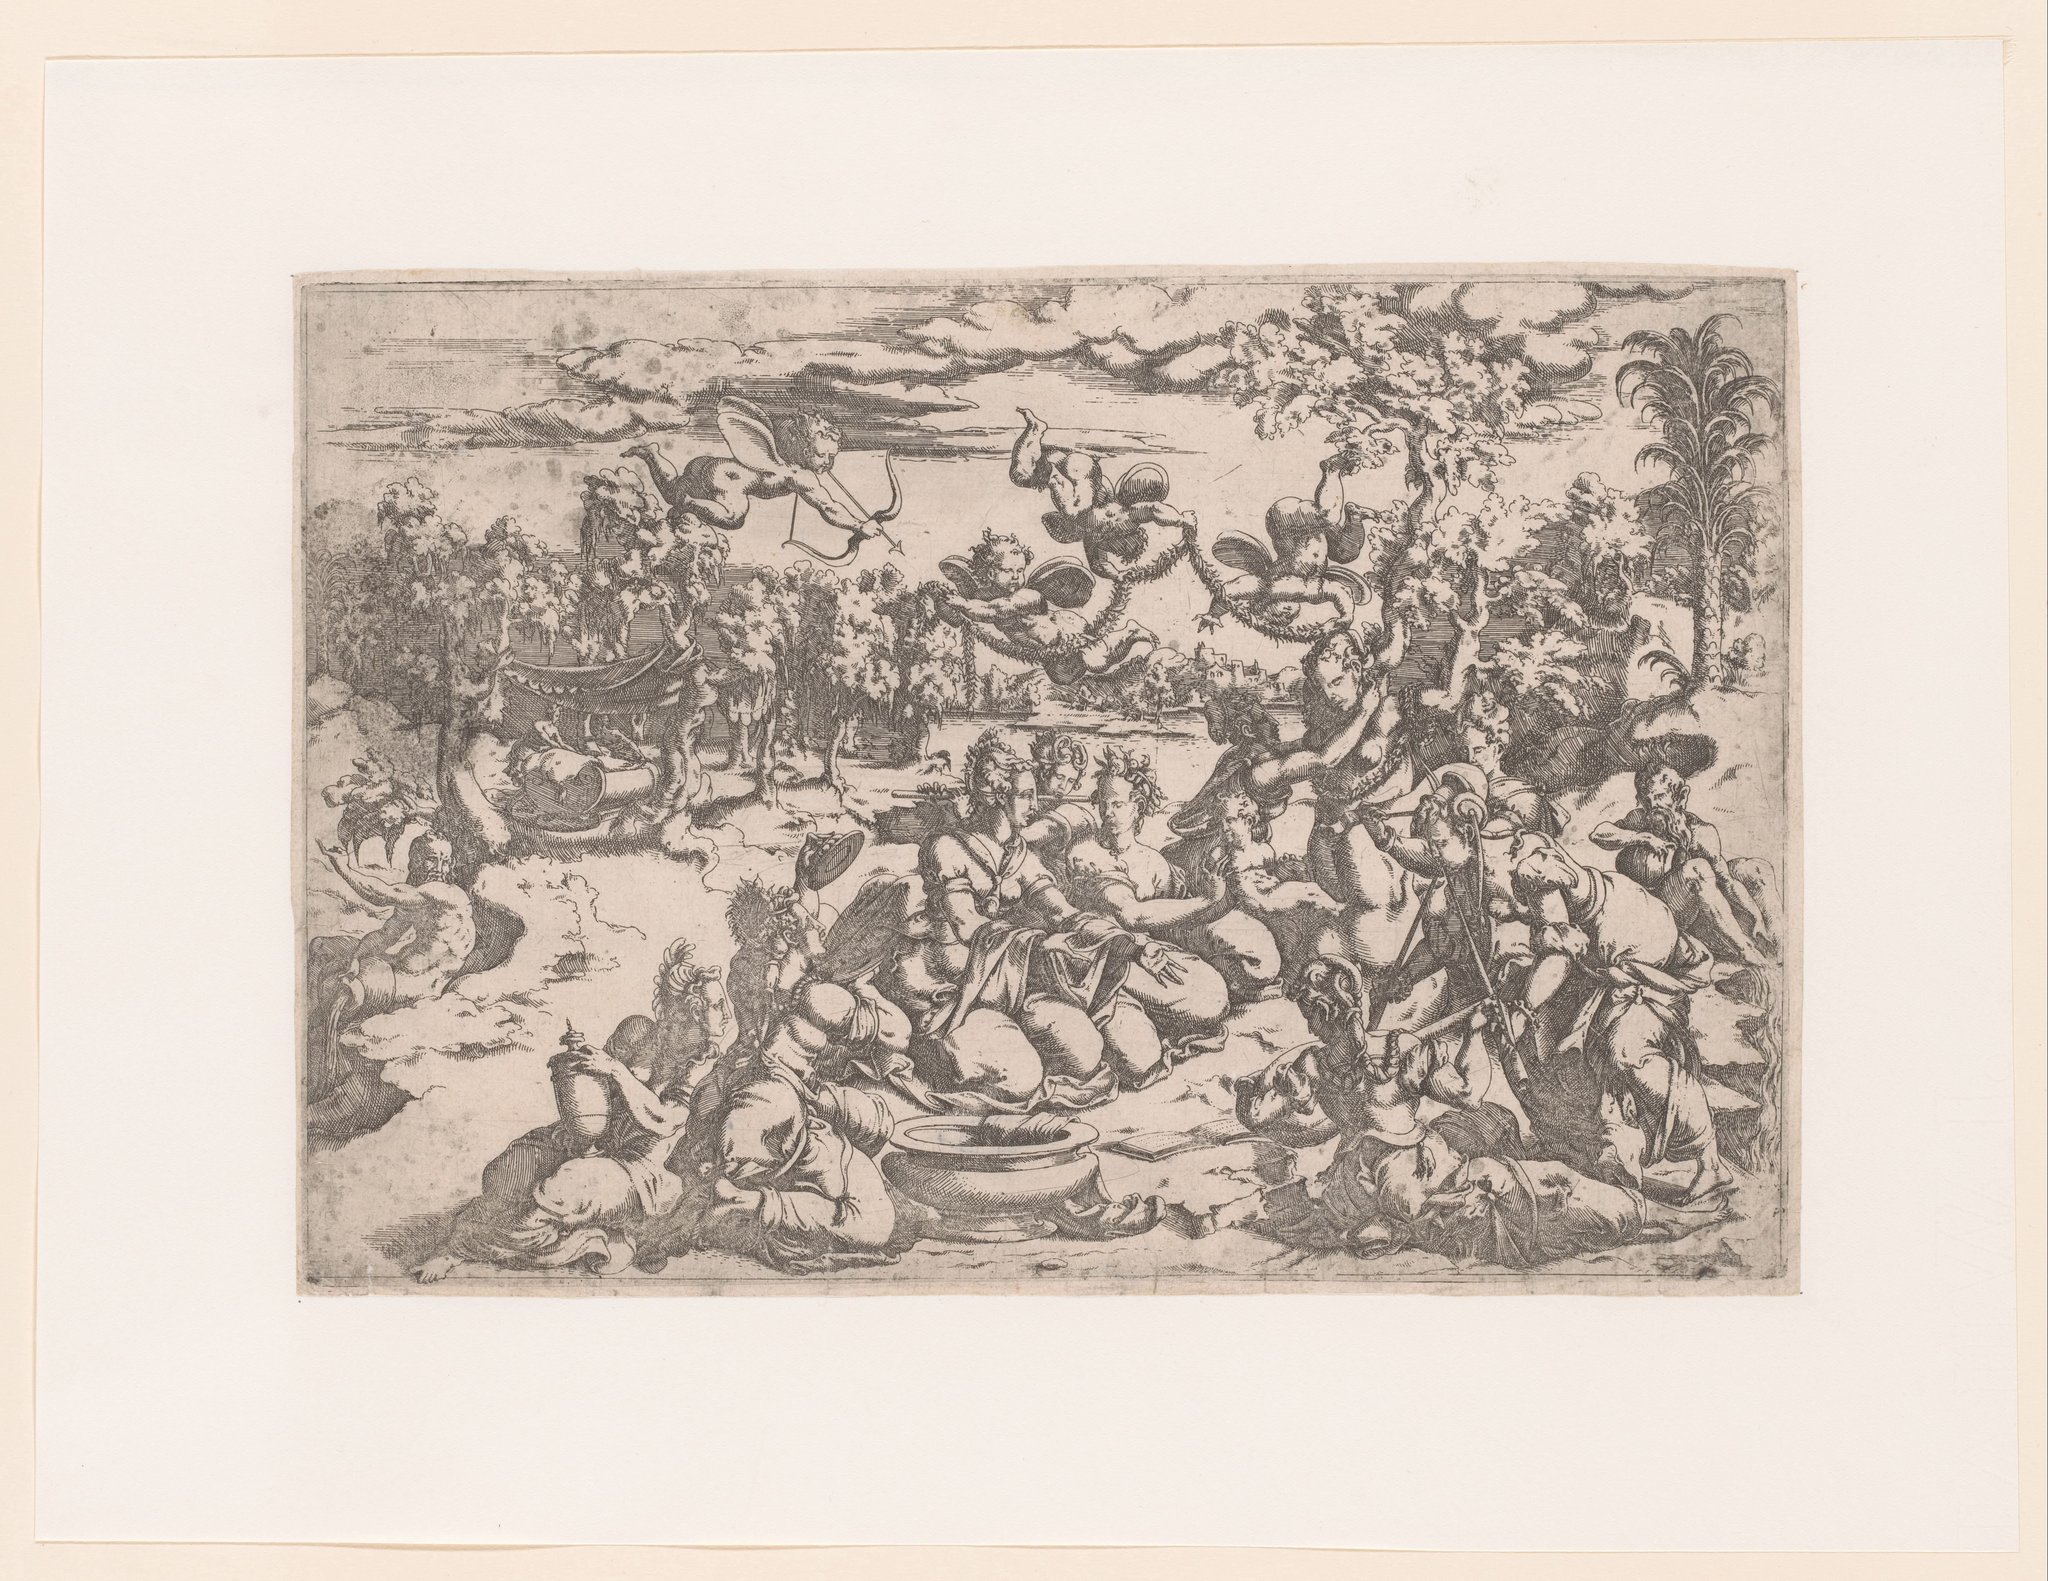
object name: print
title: Geboorte van Adonis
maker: Anonymous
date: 1540-1580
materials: paper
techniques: etching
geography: france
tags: birth of adonis: the tree splits open to release the baby; the naiads take care of him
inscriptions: collector's mark: Lugt 2228